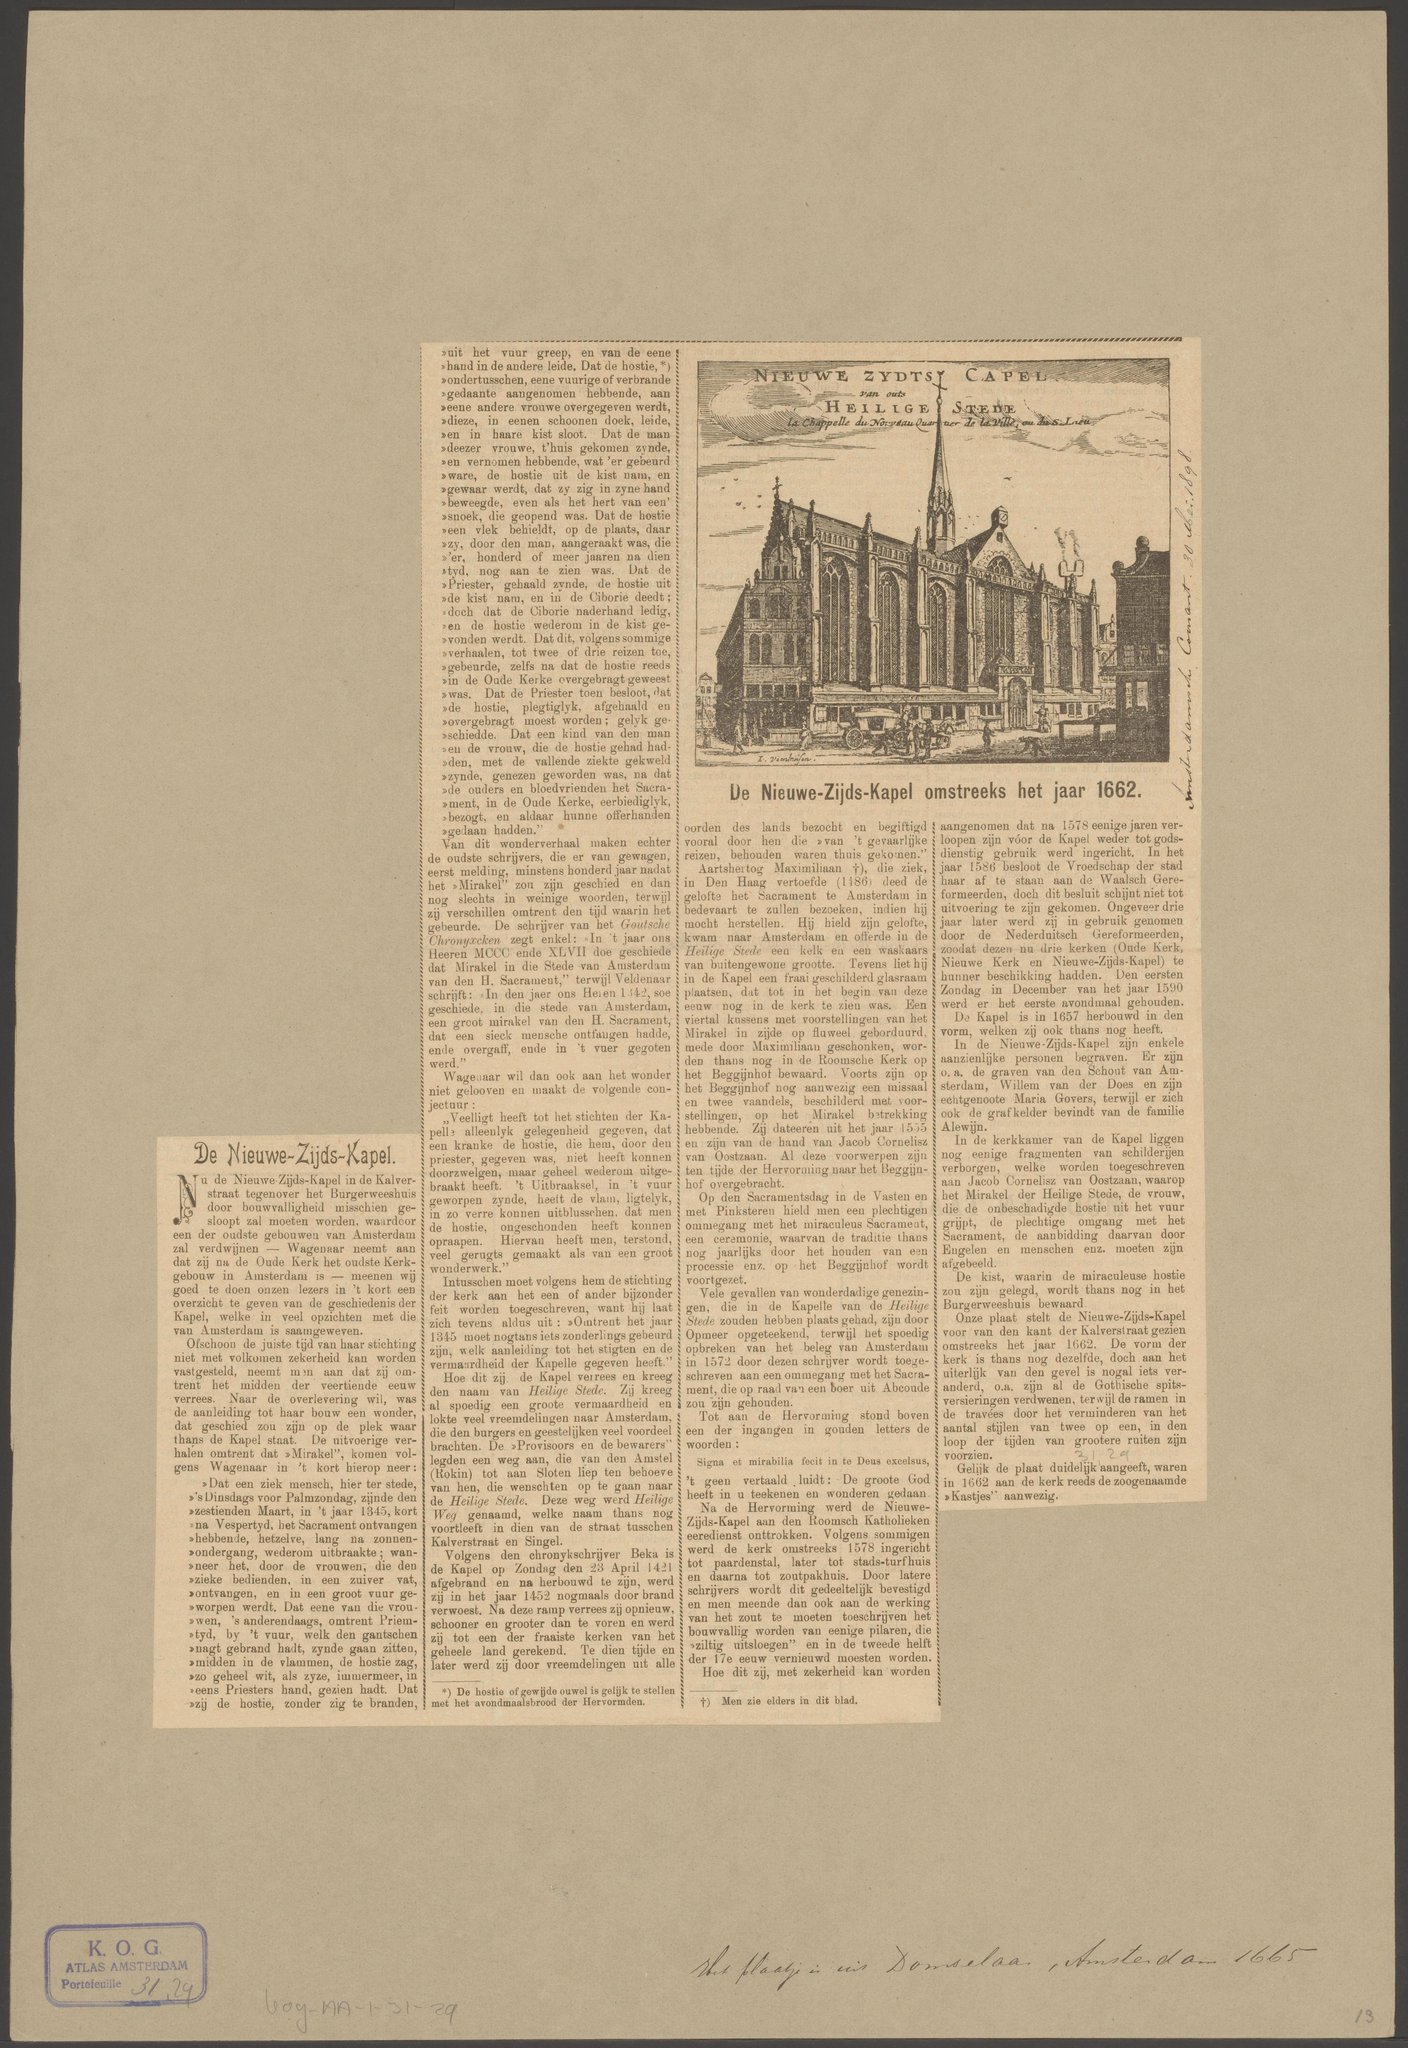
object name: photomechanical print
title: Gezicht op de Nieuwezijds Kapel te Amsterdam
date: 1898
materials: paper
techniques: letterpress printing, line block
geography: amsterdam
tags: church (exterior) - qq - small church, chapel, street (+ city(-scape) with figures, staffage)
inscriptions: collector's mark: Lugt 1641b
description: Onderwerpsrubriek binnen de Atlas Amsterdam: Kerkwezen: Hervormde Gemeente: Nieuwezijds Kapel.